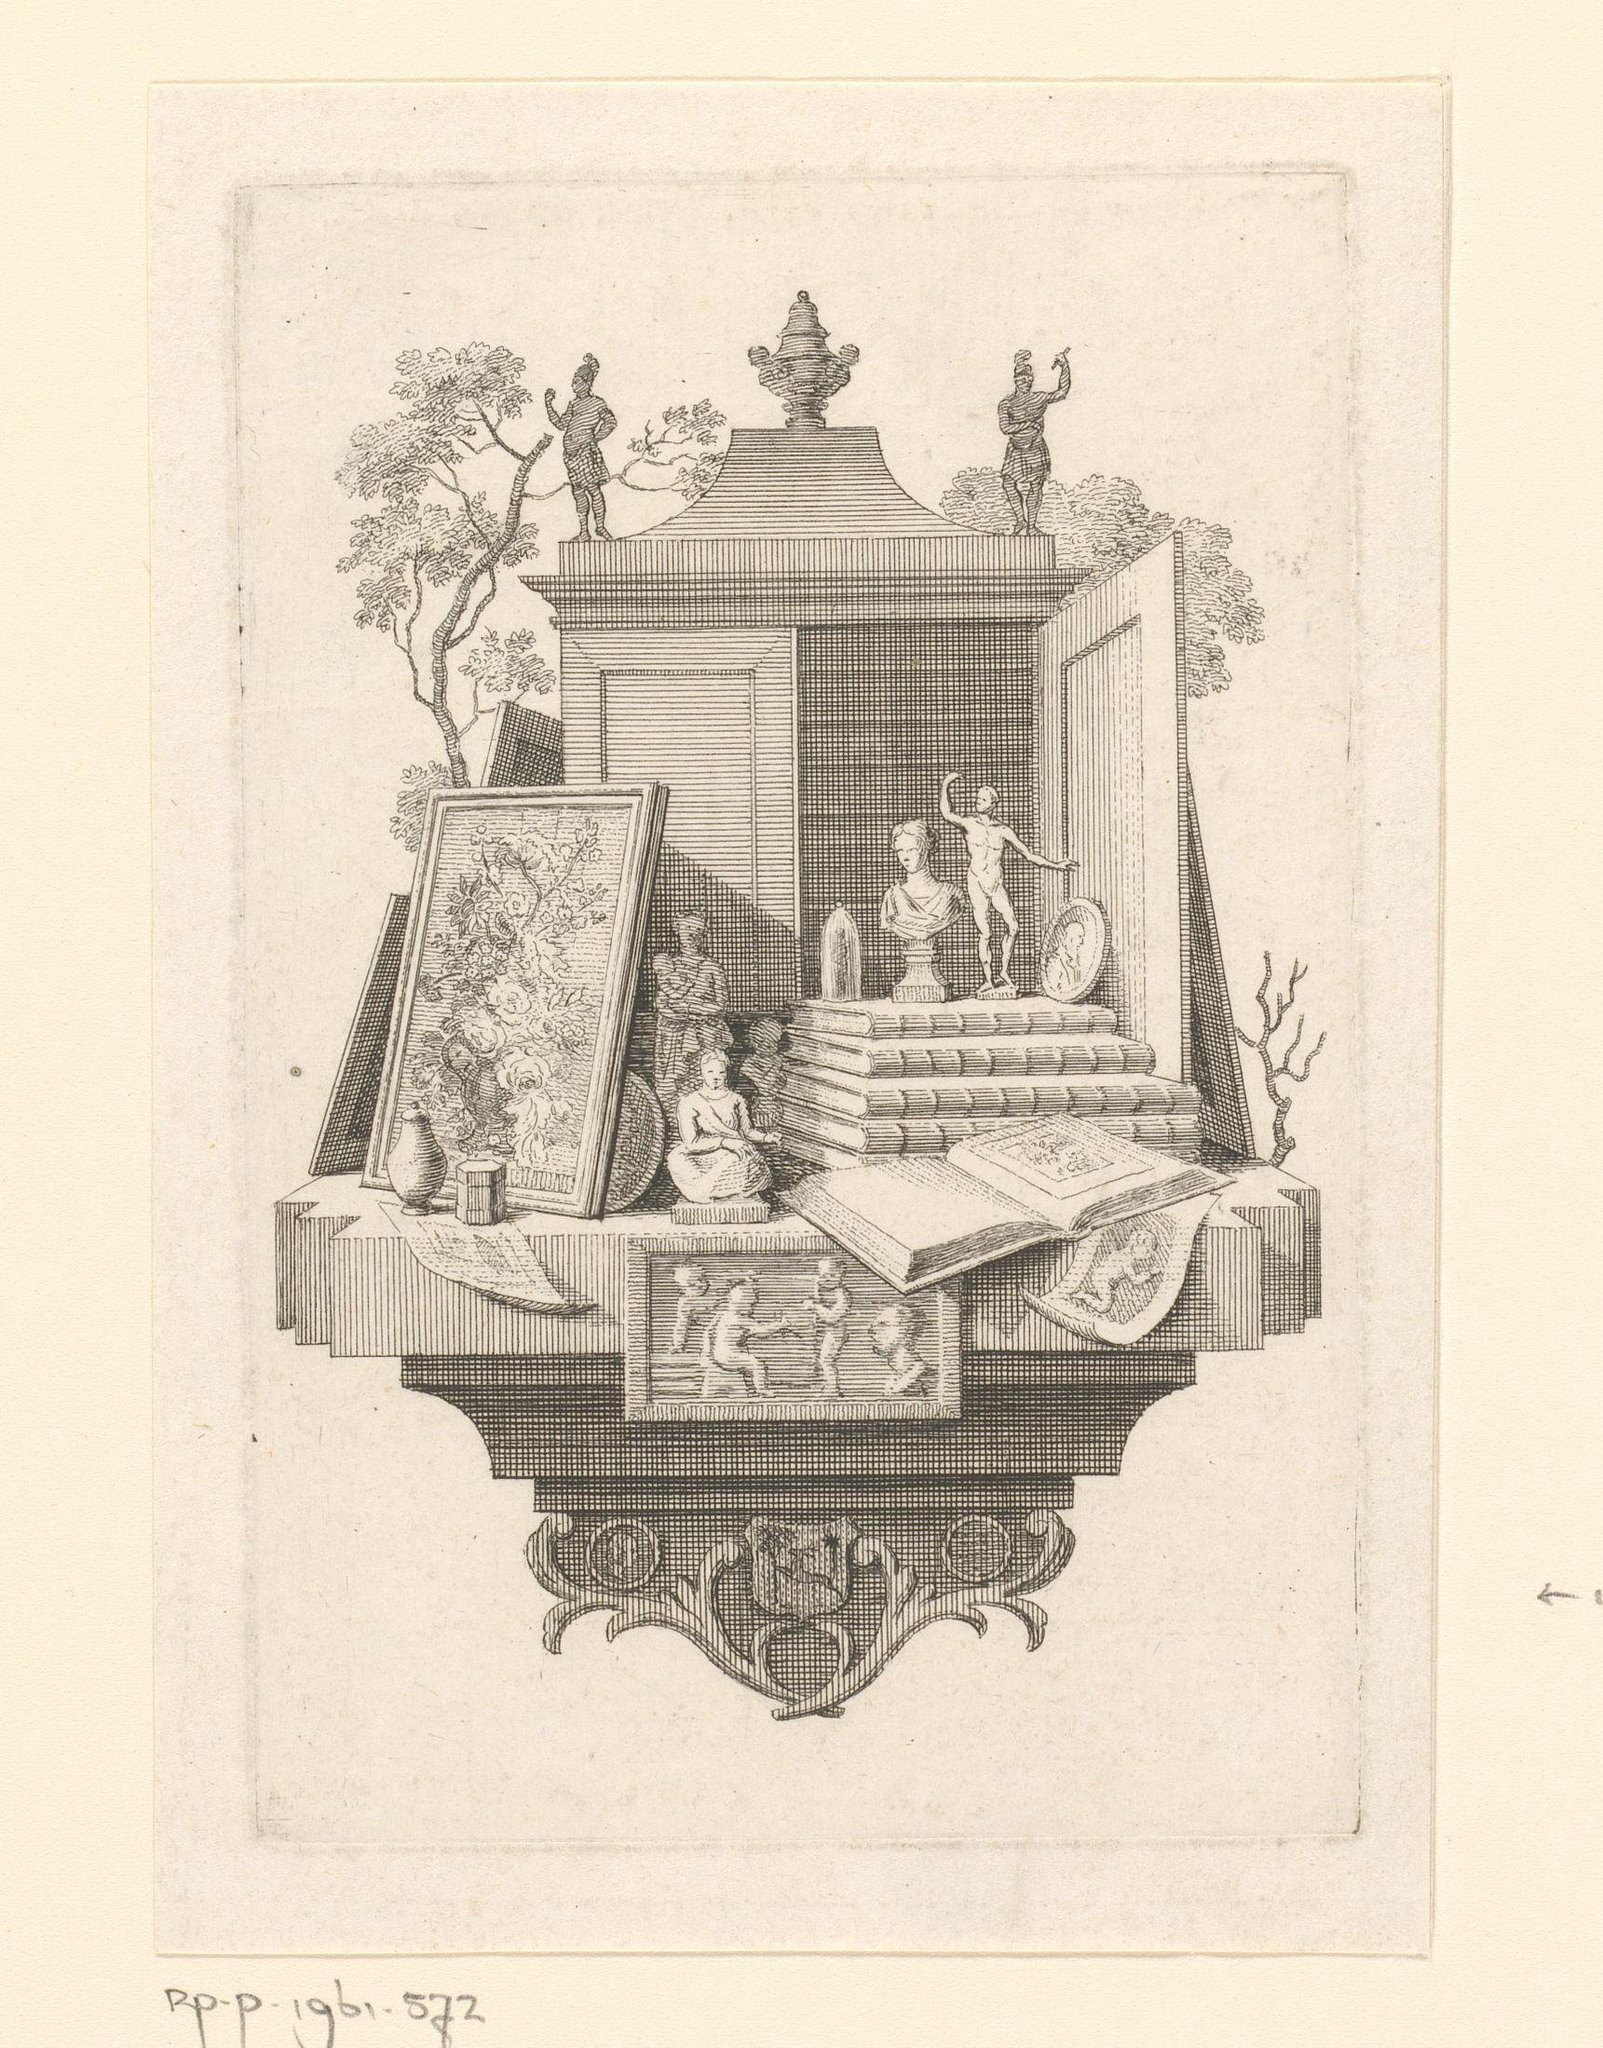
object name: print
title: Verzamelaarskabinet of kunstkast met boeken, prenten en sculptuur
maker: Anonymous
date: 1700-1799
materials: paper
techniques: engraving, etching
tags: print, e.g.: engraving, etching, lithograph, 'kunstschrank', book, piece of sculpture, reproduction of a piece of sculpture